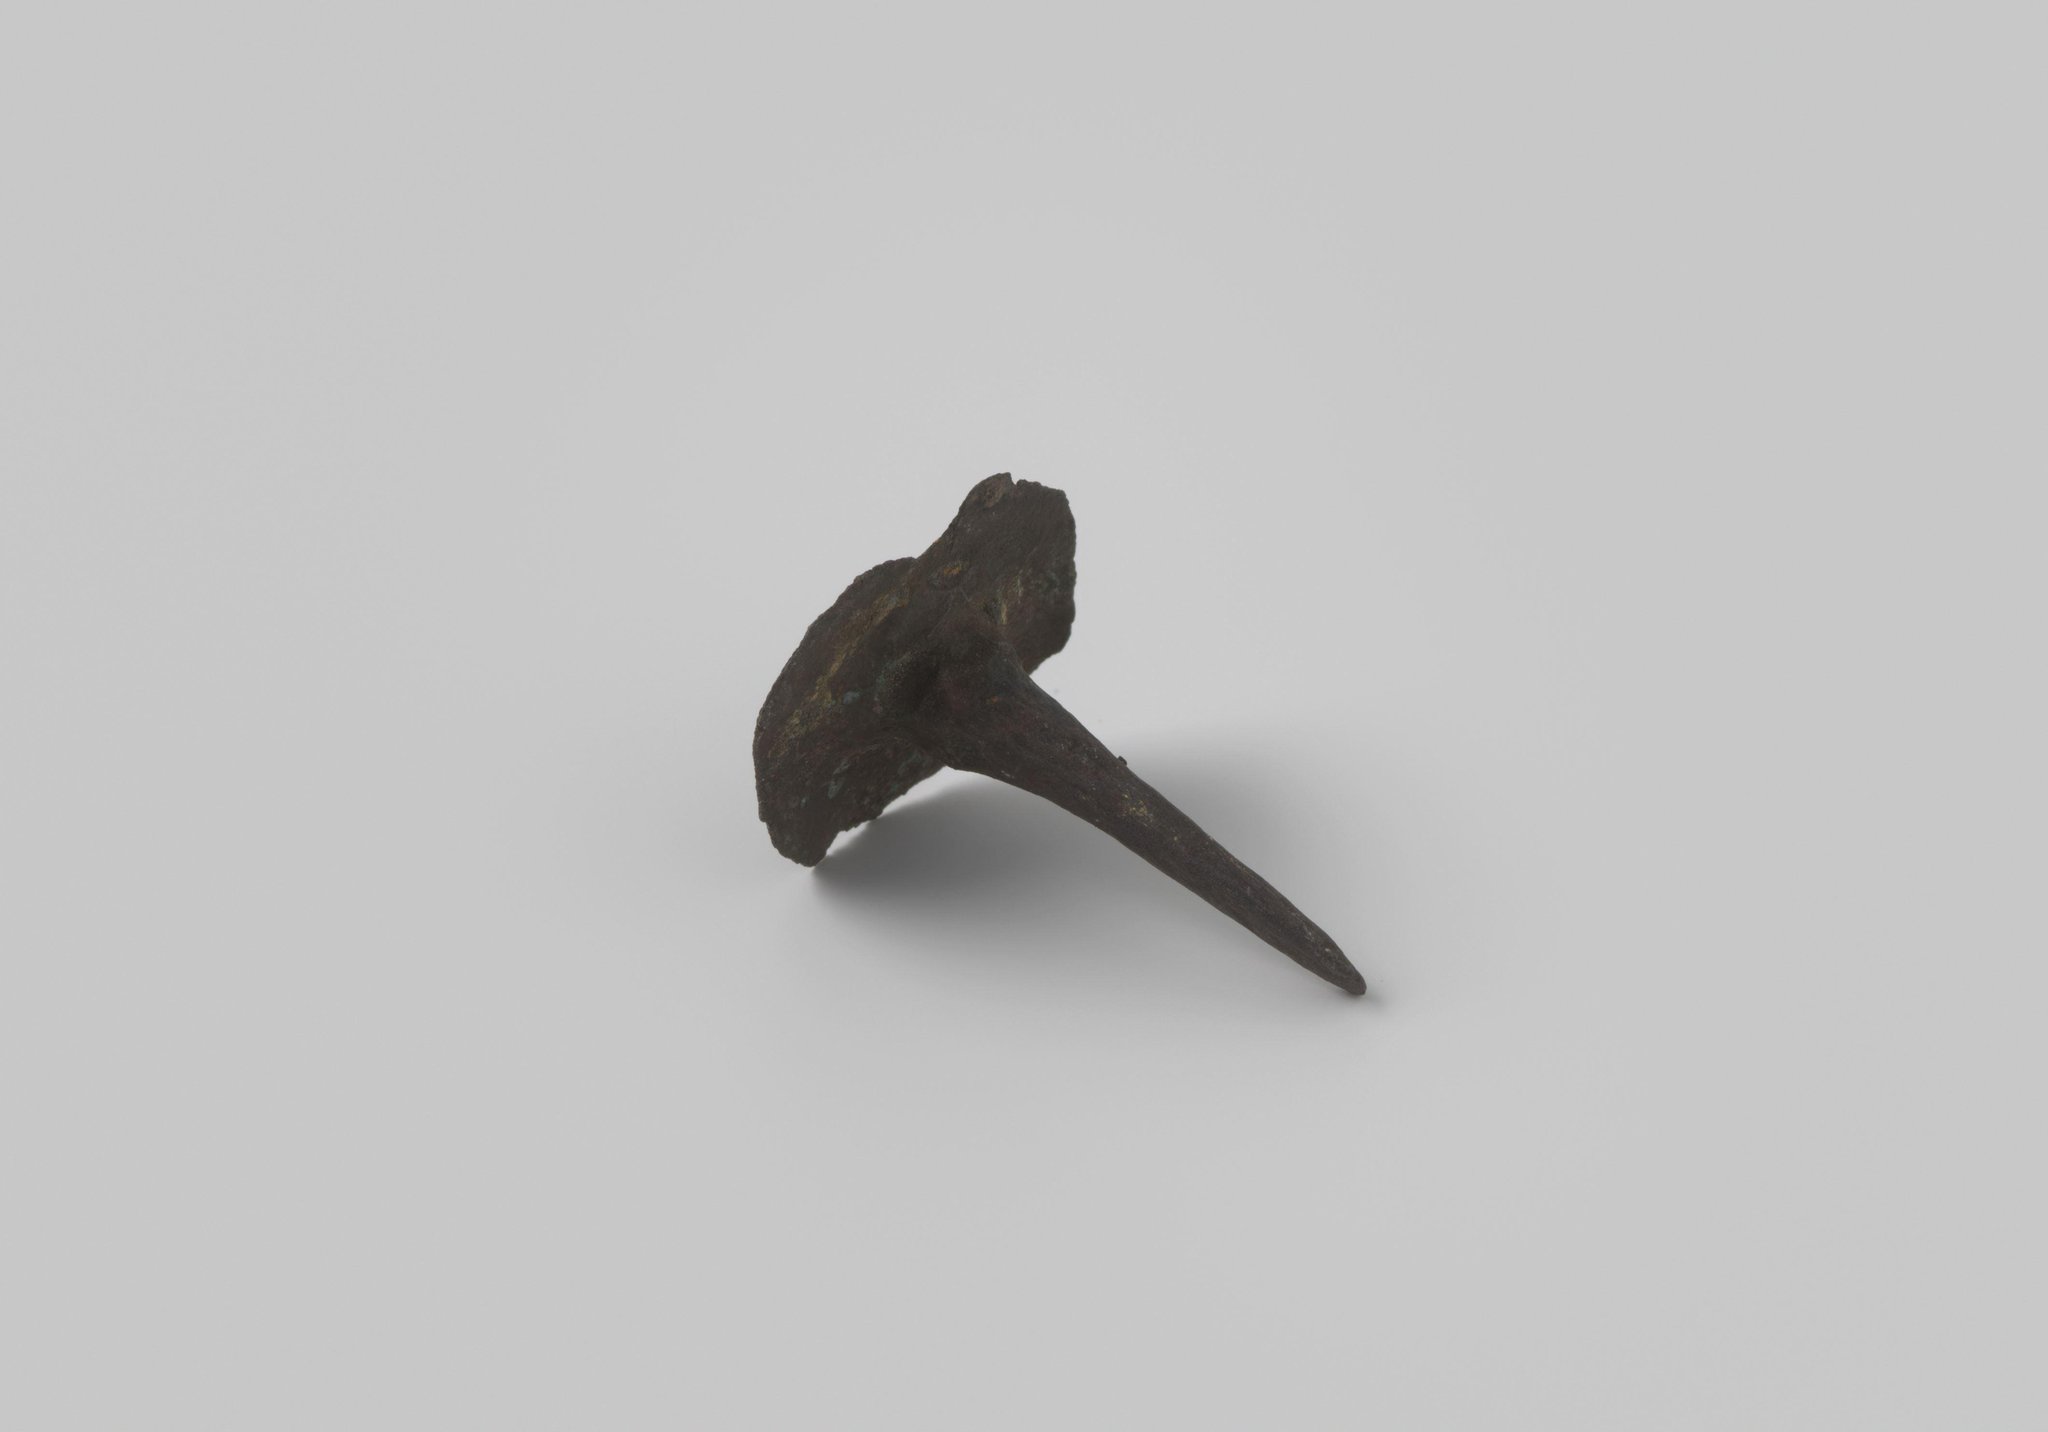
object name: nagel, spijker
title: Spijker, gevonden bij V.O.C.-schip Witte Leeuw, mogelijk afkomstig van Zeelelie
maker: Anonymous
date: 1613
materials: iron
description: Spijker van V.O.C.-schip Witte Leeuw. Datering onduidelijk. Mogelijk 18e-eeuws en kan dus geen onderdeel van de Witte Leeuw zijn. Onduidelijk is of het object van de site komt of dat het later is vermengd, mogelijk met materiaal van de Zeelelie.